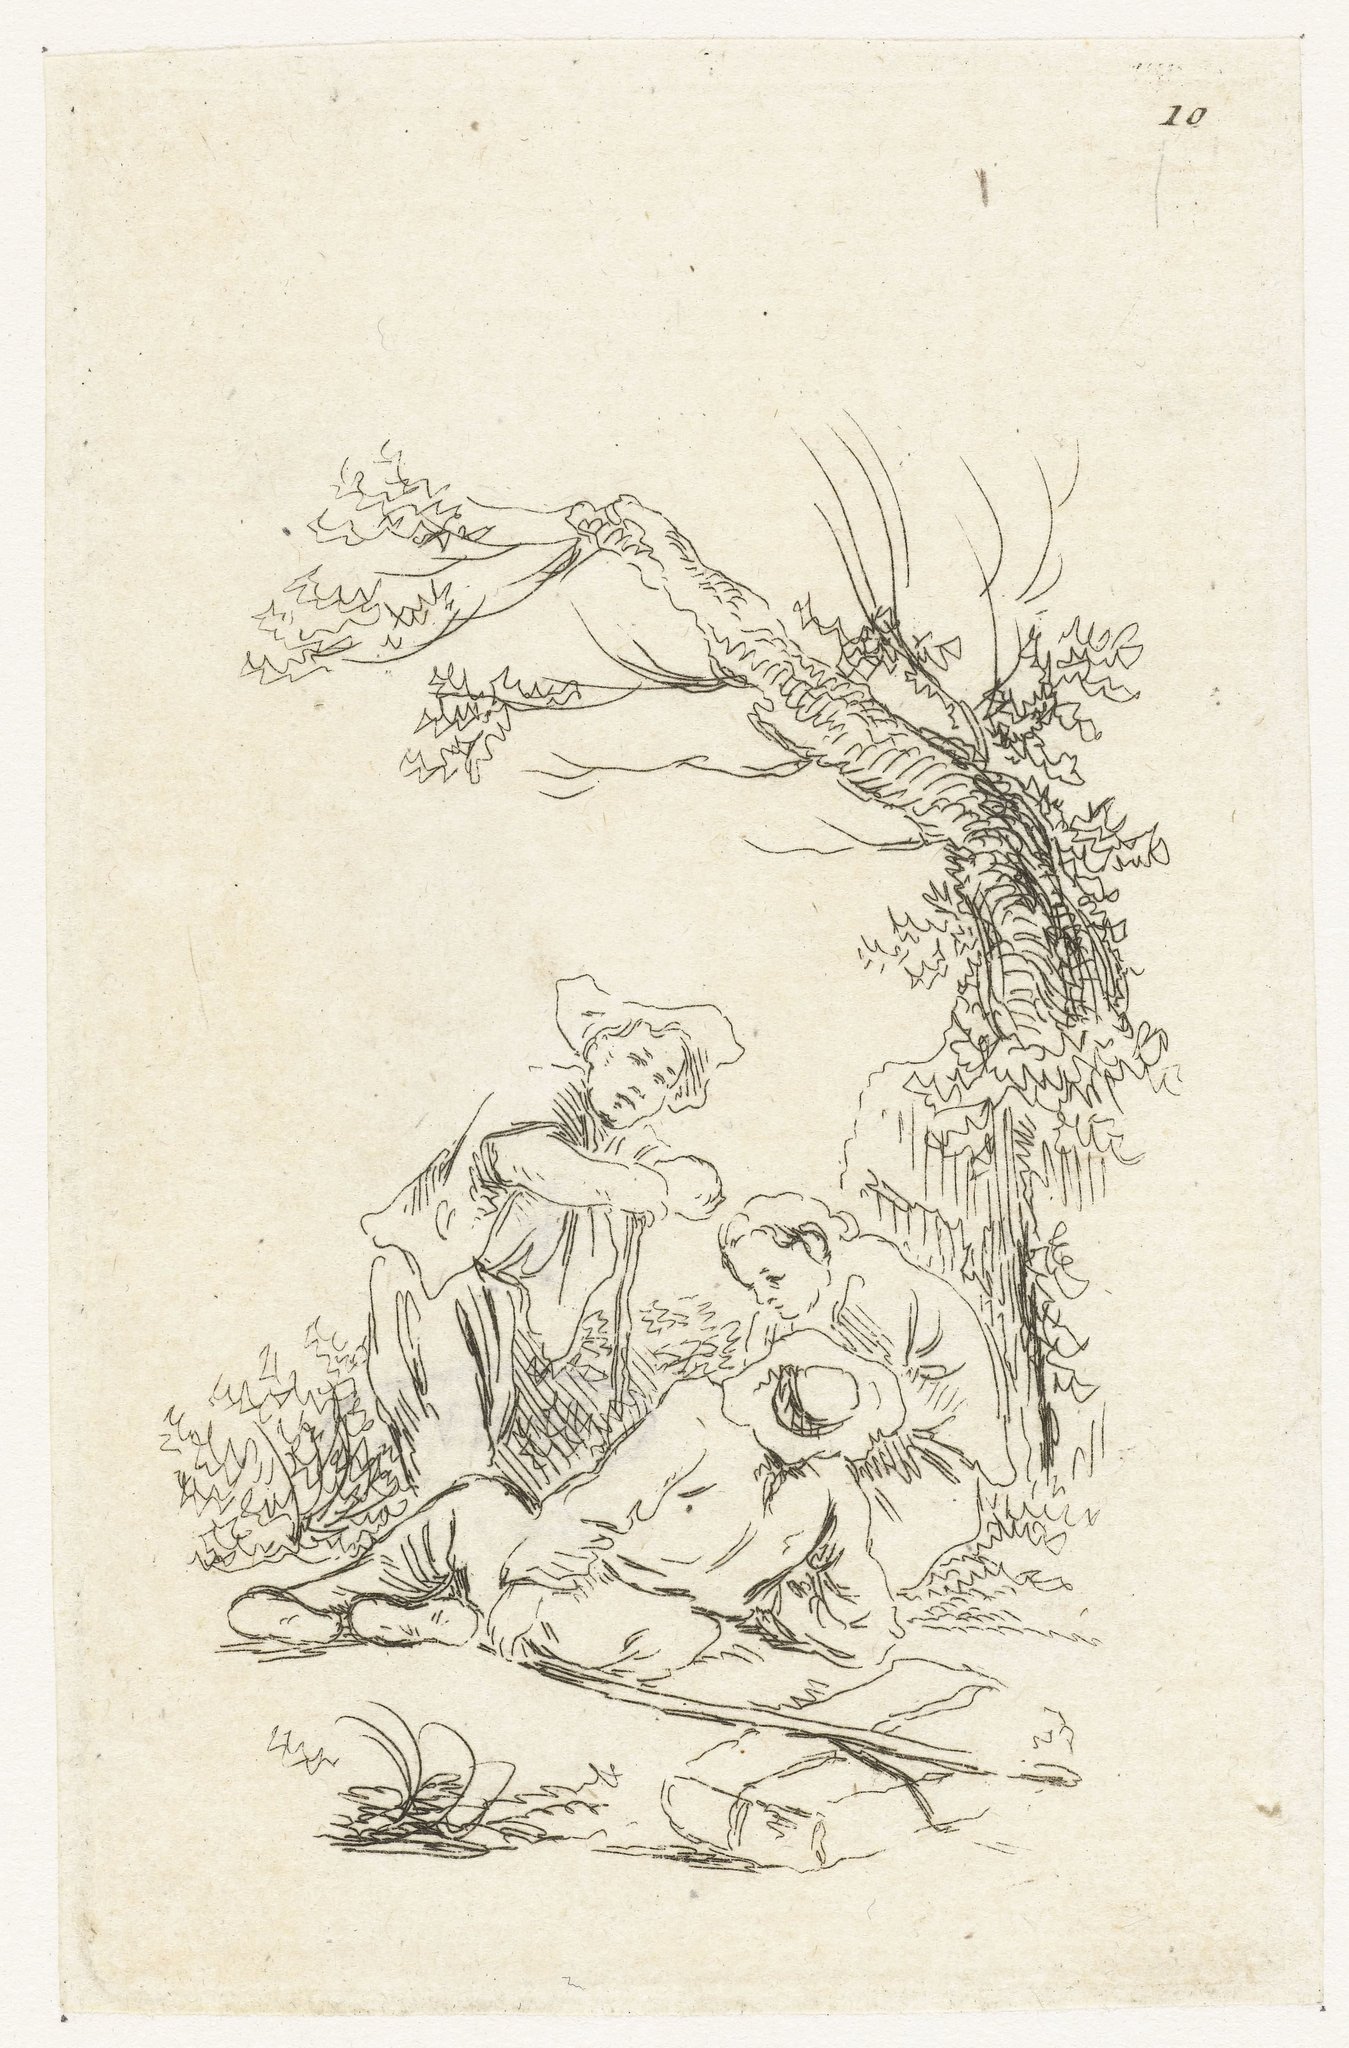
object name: print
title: Drie reizigers rustend onder een boom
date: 1727-1755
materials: paper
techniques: etching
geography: france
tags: the (nude) human figure; 'corpo humano' (ripa) (+ three persons), rest, immobility, stasis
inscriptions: collector's mark: Lugt 2228, collector's mark: Lugt 2760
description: Twee mannen en een vrouw rustend onder een boom. De mannen hebben een wandelstaf bij zich.